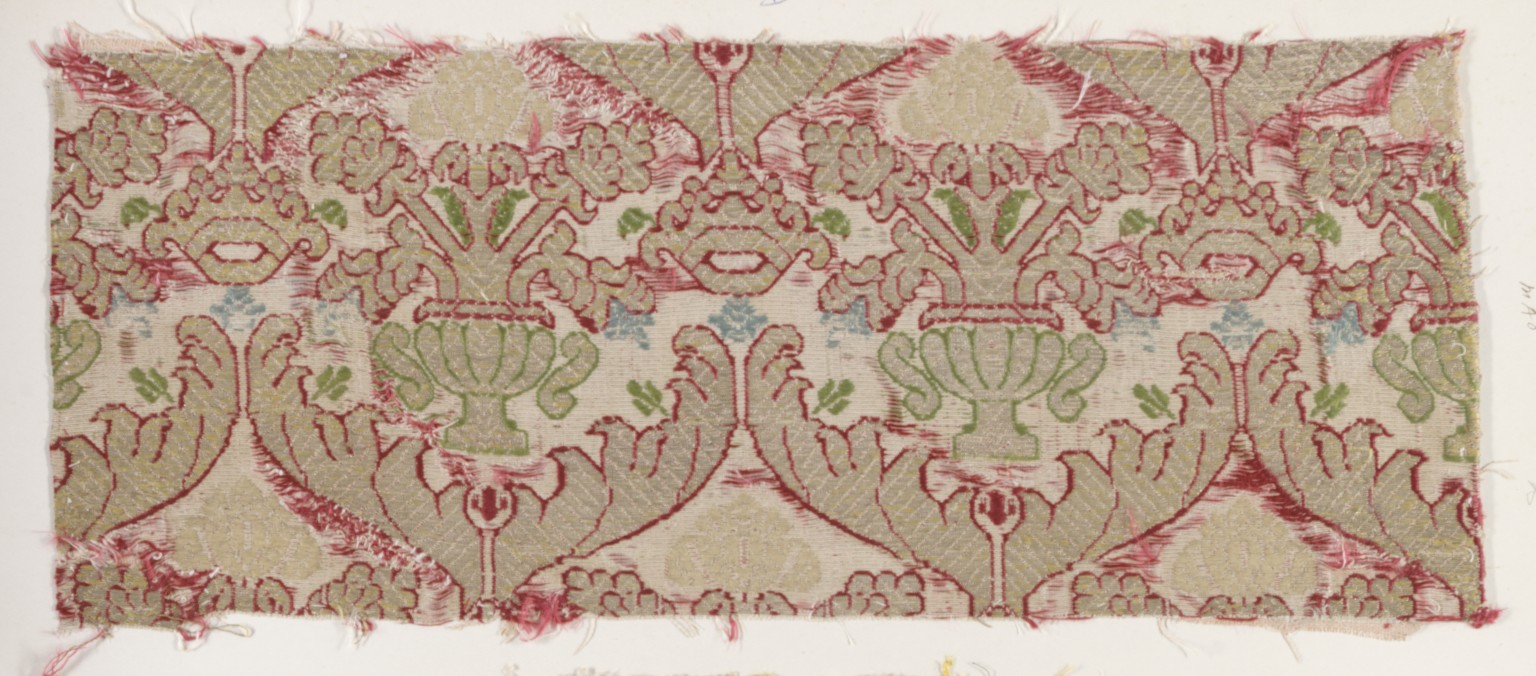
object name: fragment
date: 1501-1600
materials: metal, silk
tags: flowers